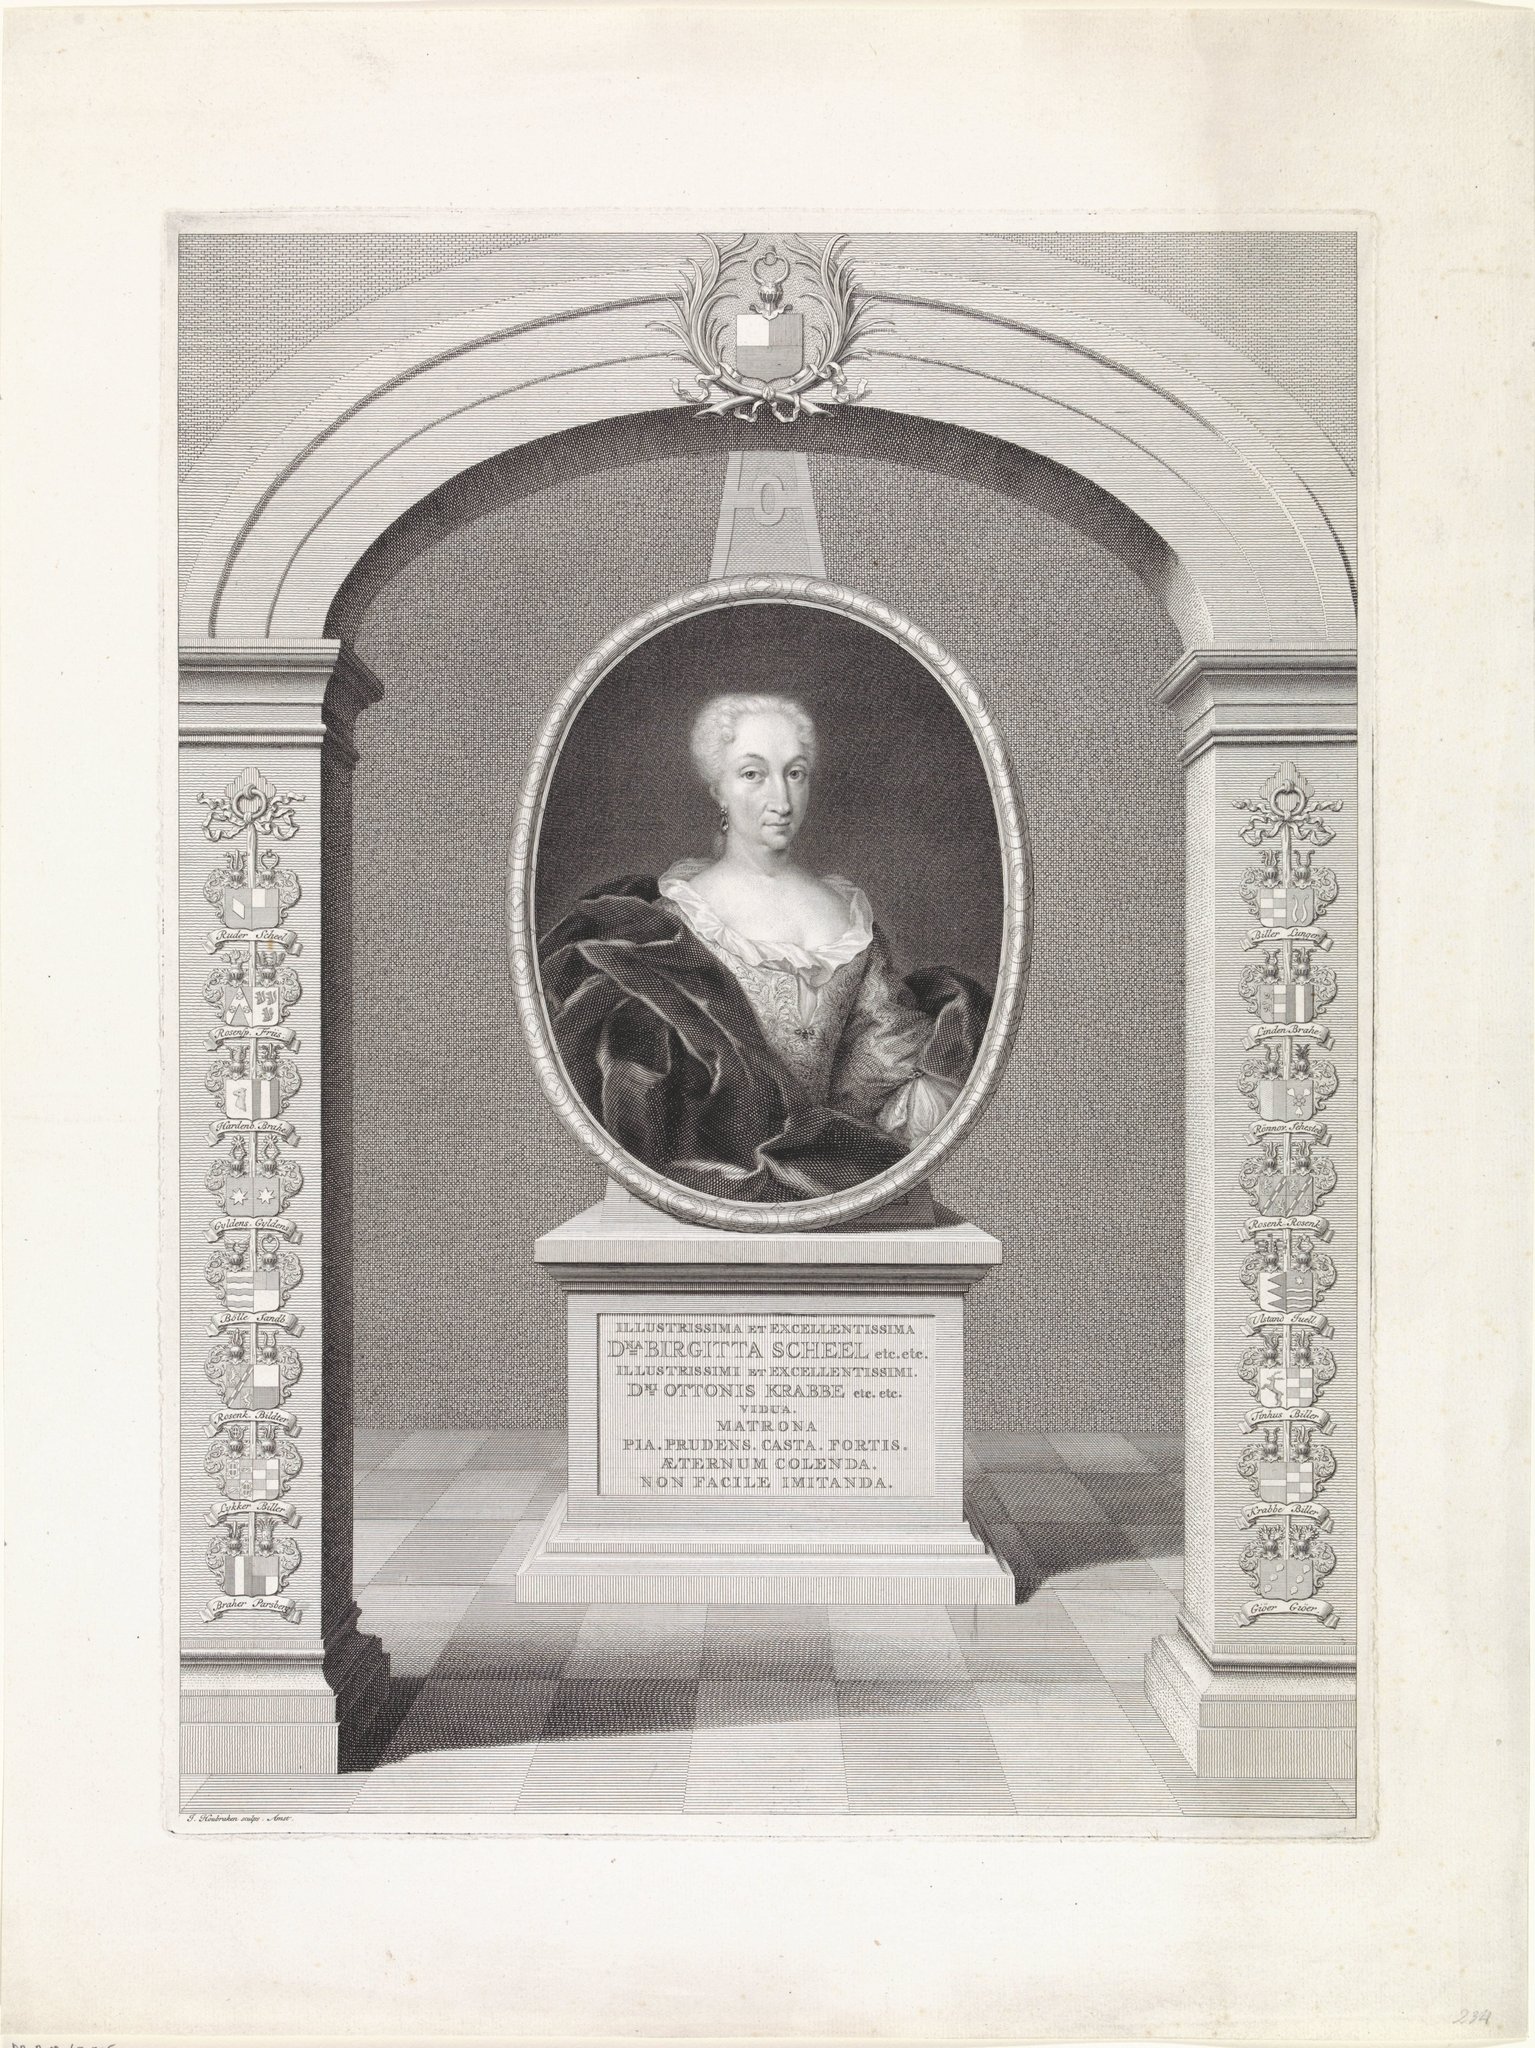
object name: print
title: Portret van Birgitta Scheel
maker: jacob houbraken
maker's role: draughtsman, print maker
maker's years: 1698-1780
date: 1708-1780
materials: paper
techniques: engraving, etching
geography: amsterdam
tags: adult woman, historical persons, armorial bearing, heraldry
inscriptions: collector's mark: Lugt 240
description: Portret van Birgitta Scheel op een piëdestal, in een toogvormige architectonische omlijsting, waarop verschillende wapenschilden.